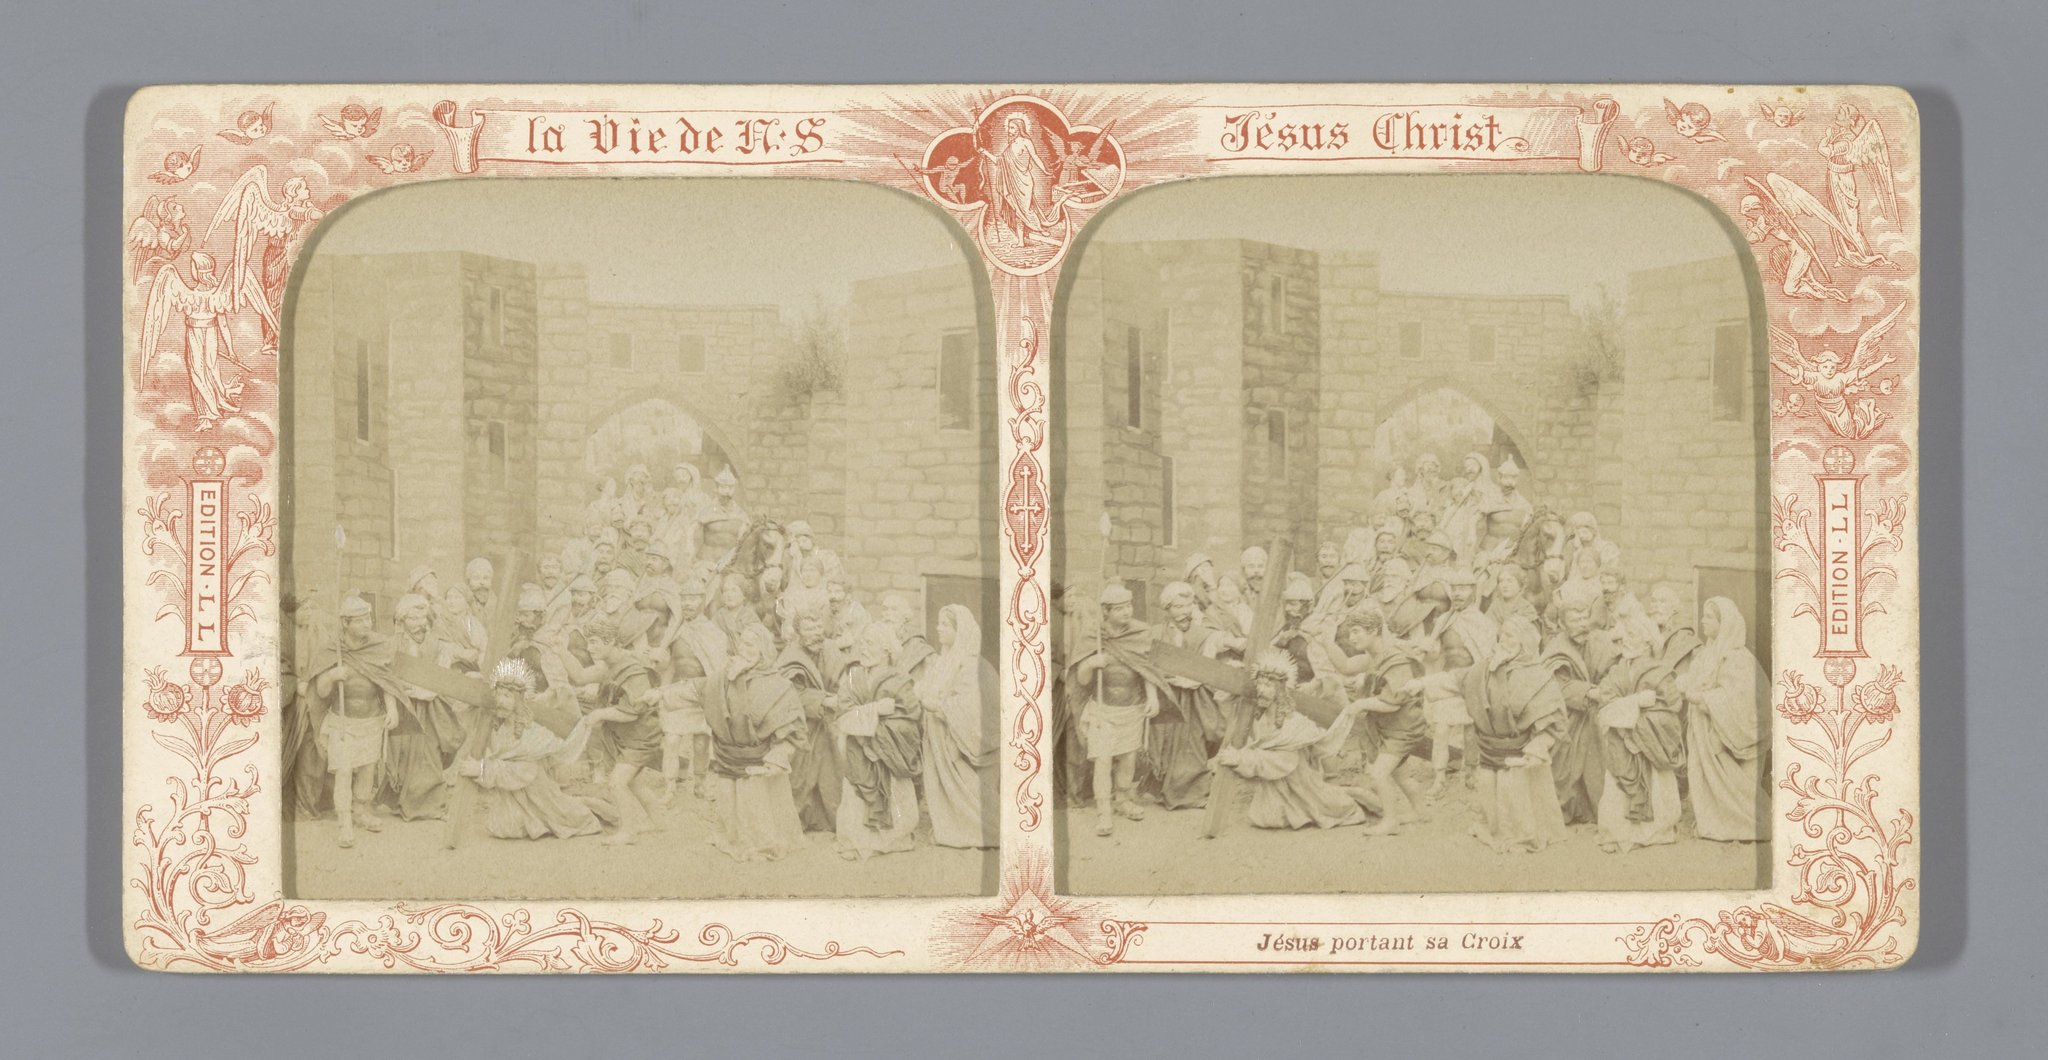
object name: tissue stereograph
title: La vie de NS Jésus Christ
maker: Anonymous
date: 1864-1905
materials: cardboard, paper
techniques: albumen print, cutting, hand coloring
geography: paris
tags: christ collapsing ~ carrying of the cross